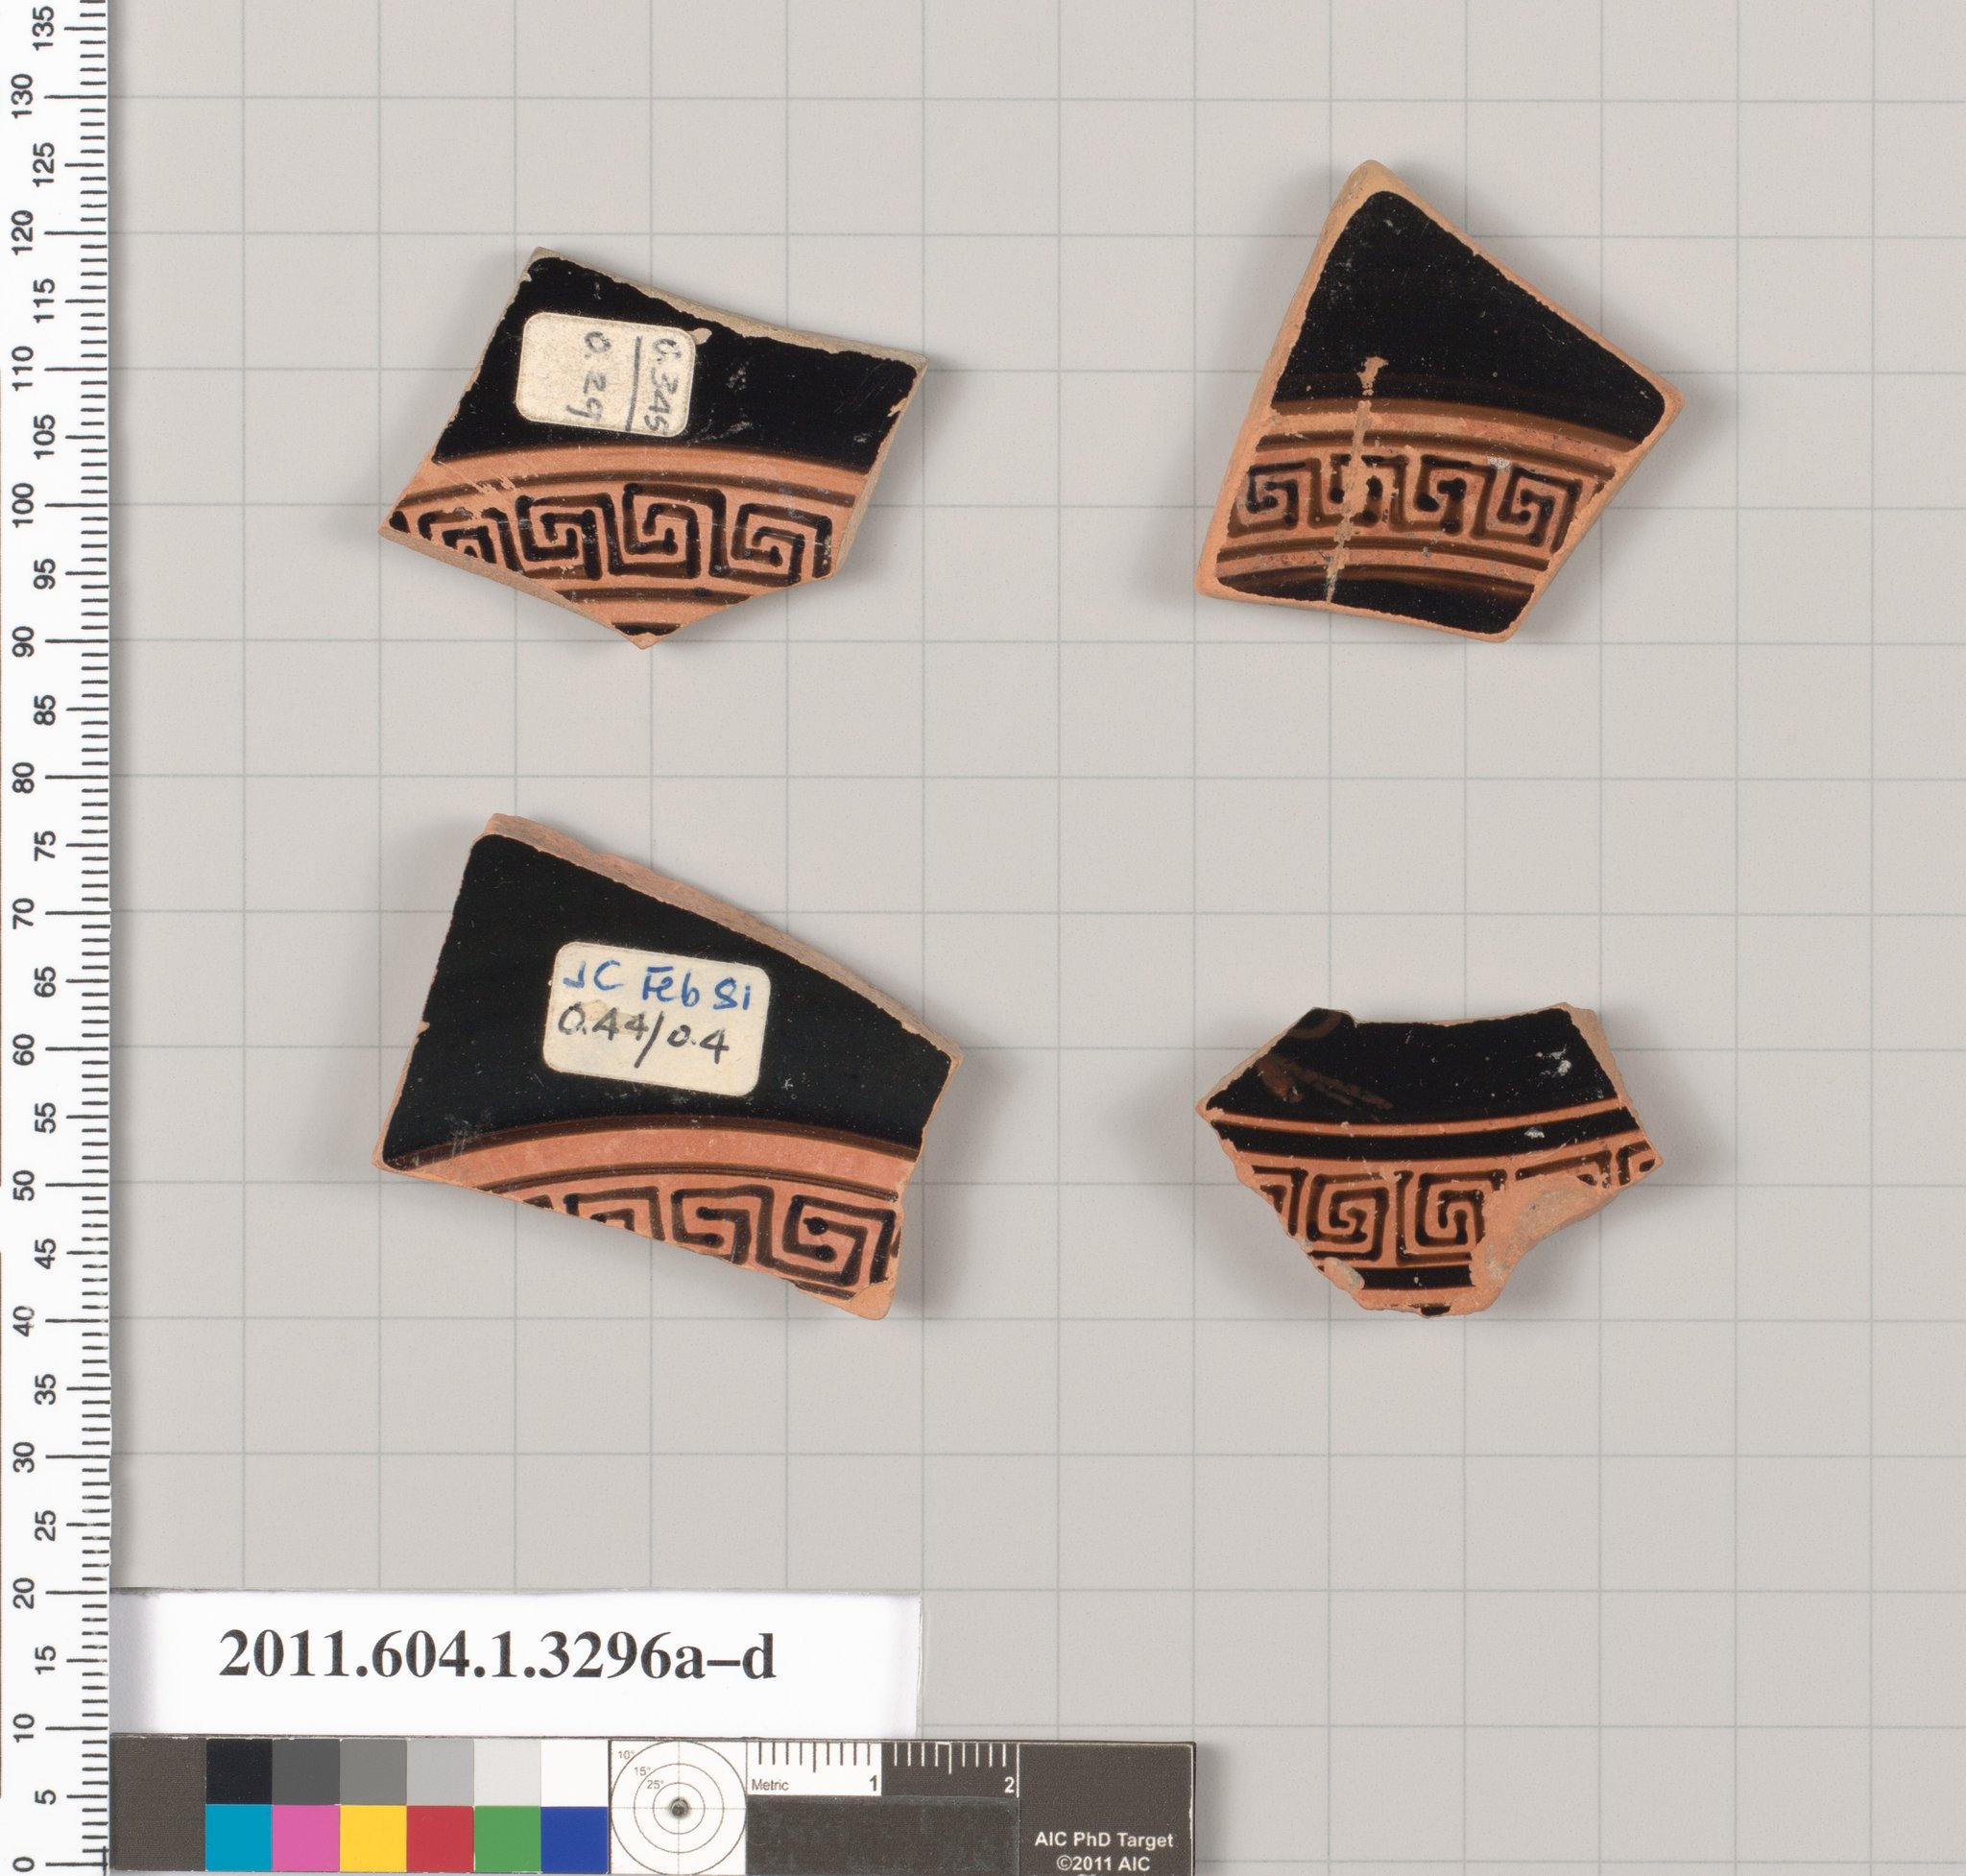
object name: kylix fragment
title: Terracotta fragments of kylikes (drinking cups)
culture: greek, attic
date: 500-480 BCE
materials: terracotta